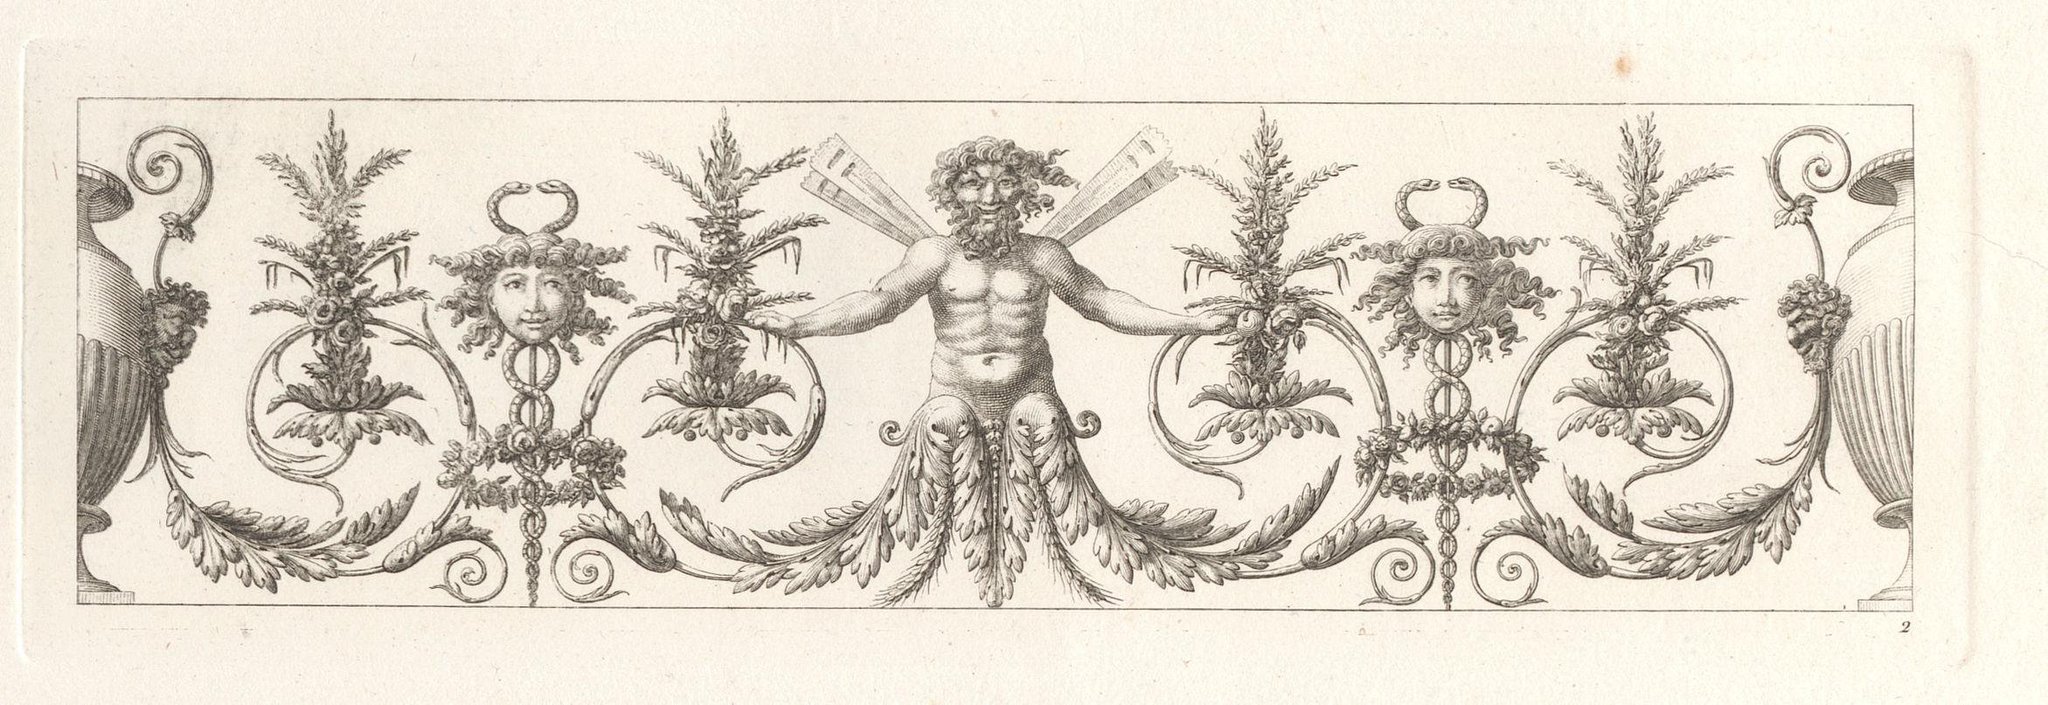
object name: album leaf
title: Ornament met caduceus aan weerszijden van een mythologisch figuur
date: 1802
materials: paper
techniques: engraving, etching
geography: paris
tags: ornament ~ arabesque, caduceus (staff with two snakes, attribute of mercury), ornament derived from plant forms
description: Doordat dit album bestaat uit meerdere, deels eerder uitgegeven prentreeksen, is de datering niet consequent. Het geheel is op de titelpagina gedateerd op 1802. Deze reeks is niet afzonderlijk gedateerd. De serietitel voor het gehele werk is "Recueil d'arabesques, contenant les loges du Vatican". De andere serietitel is de titel van de specifieke reeks binnen het geheel.